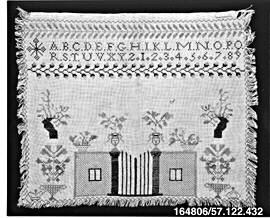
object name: sampler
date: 1801-1900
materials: canvas, silk